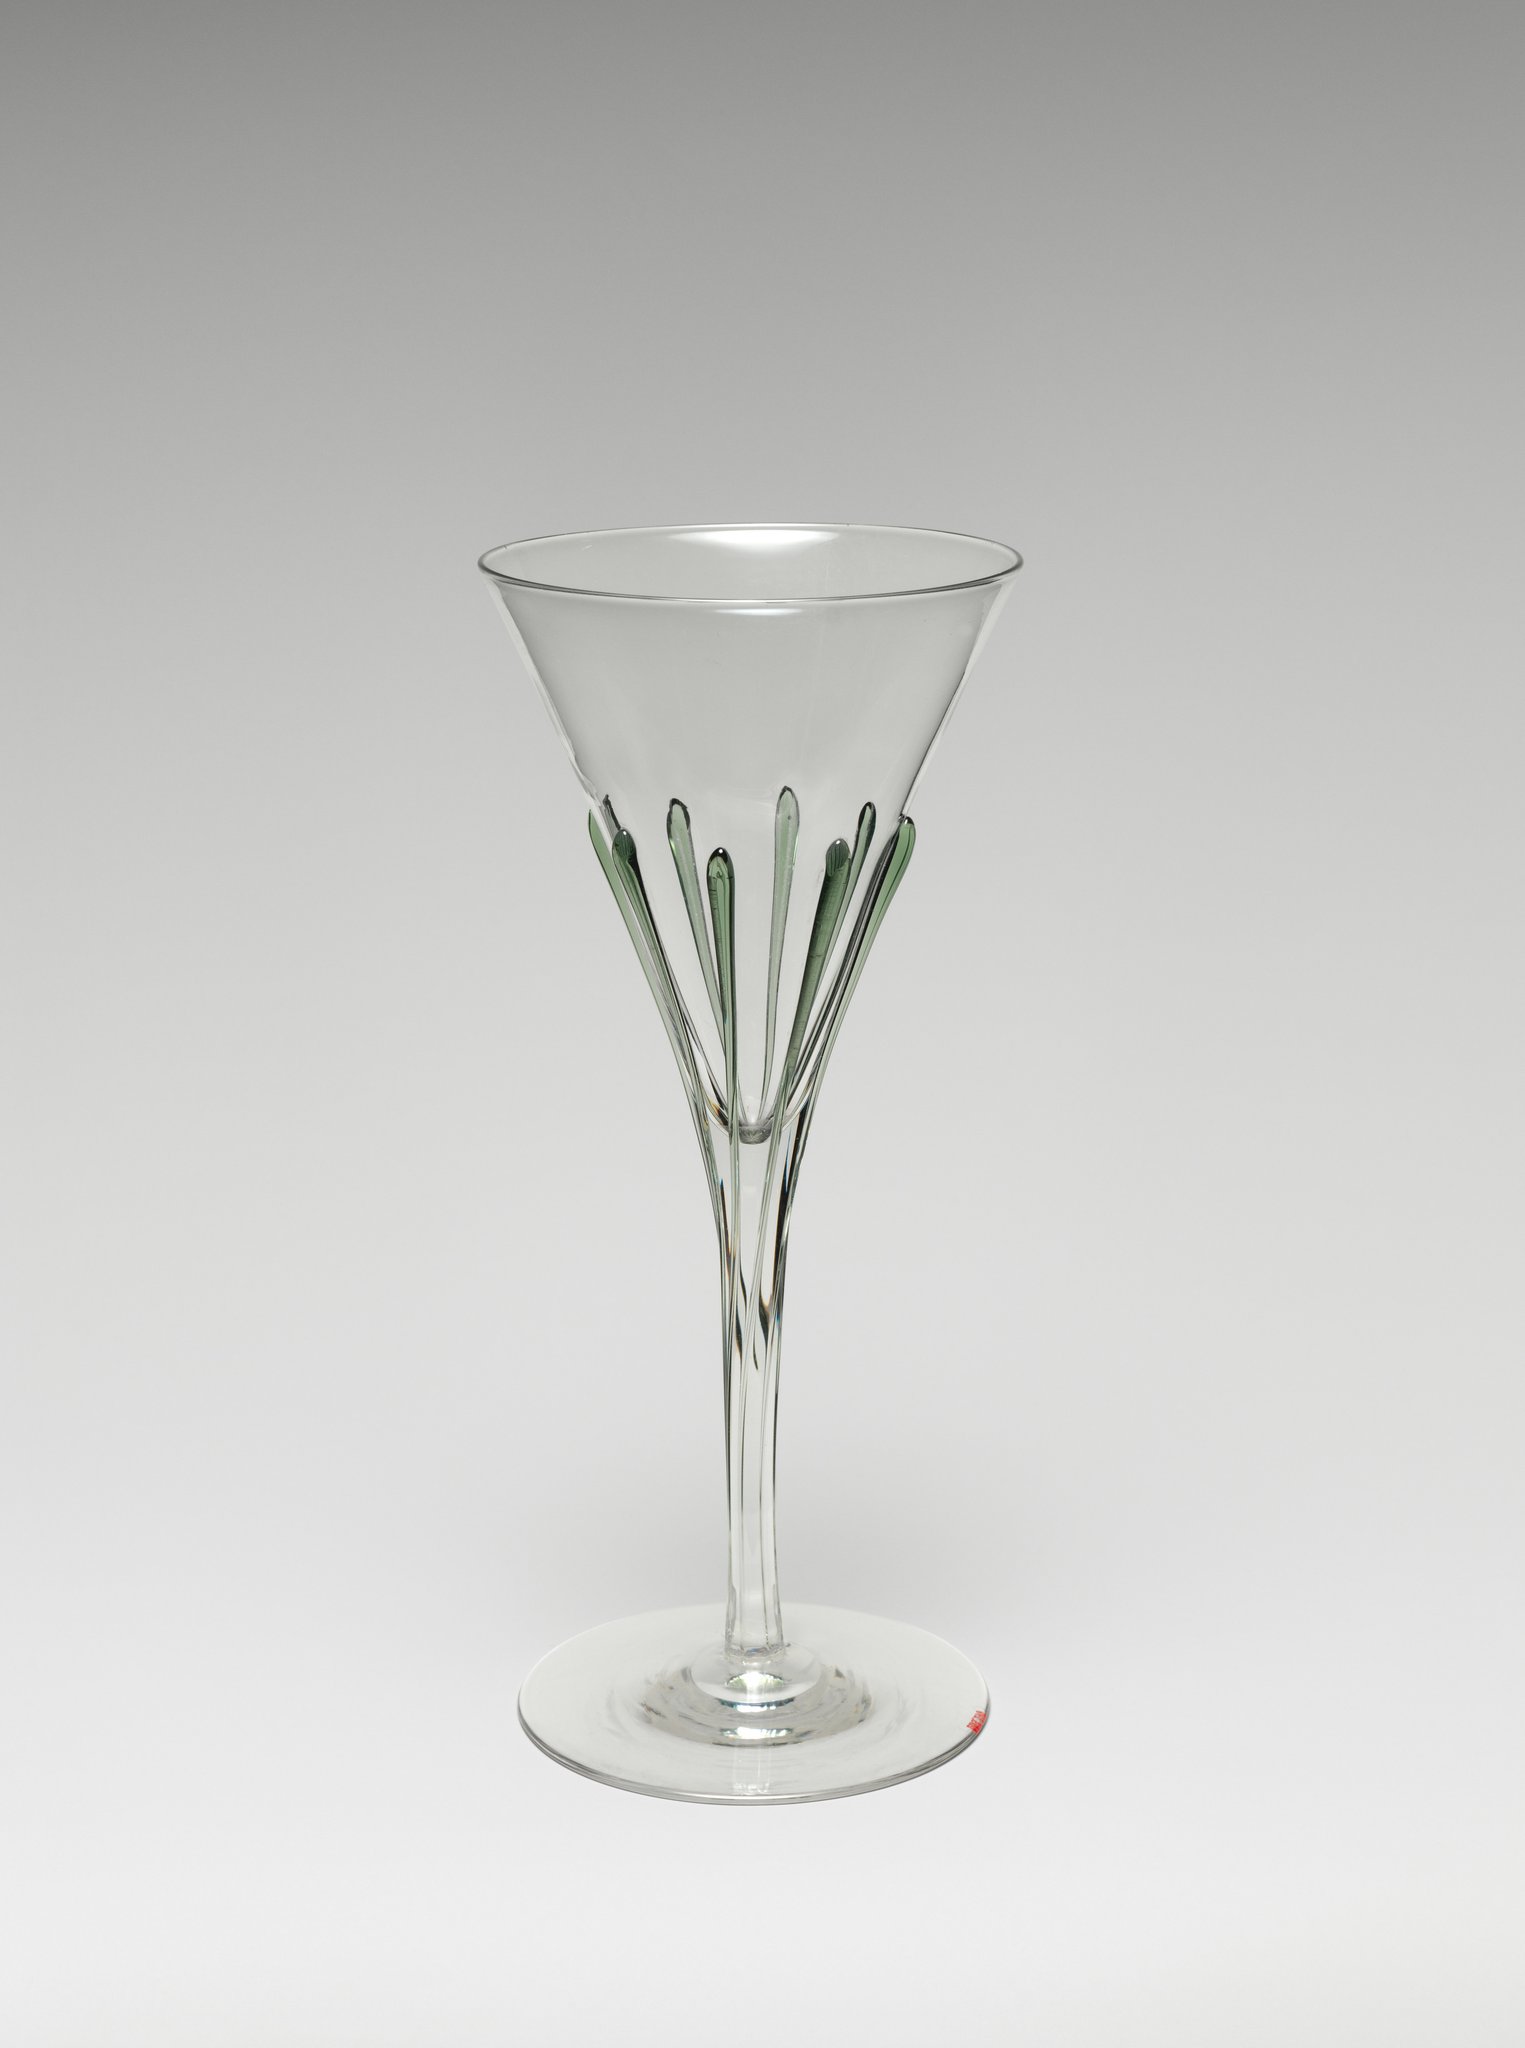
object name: wine glass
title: Tear wine glass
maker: harry powell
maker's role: designer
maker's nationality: british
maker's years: 1853-1922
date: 1899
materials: glass